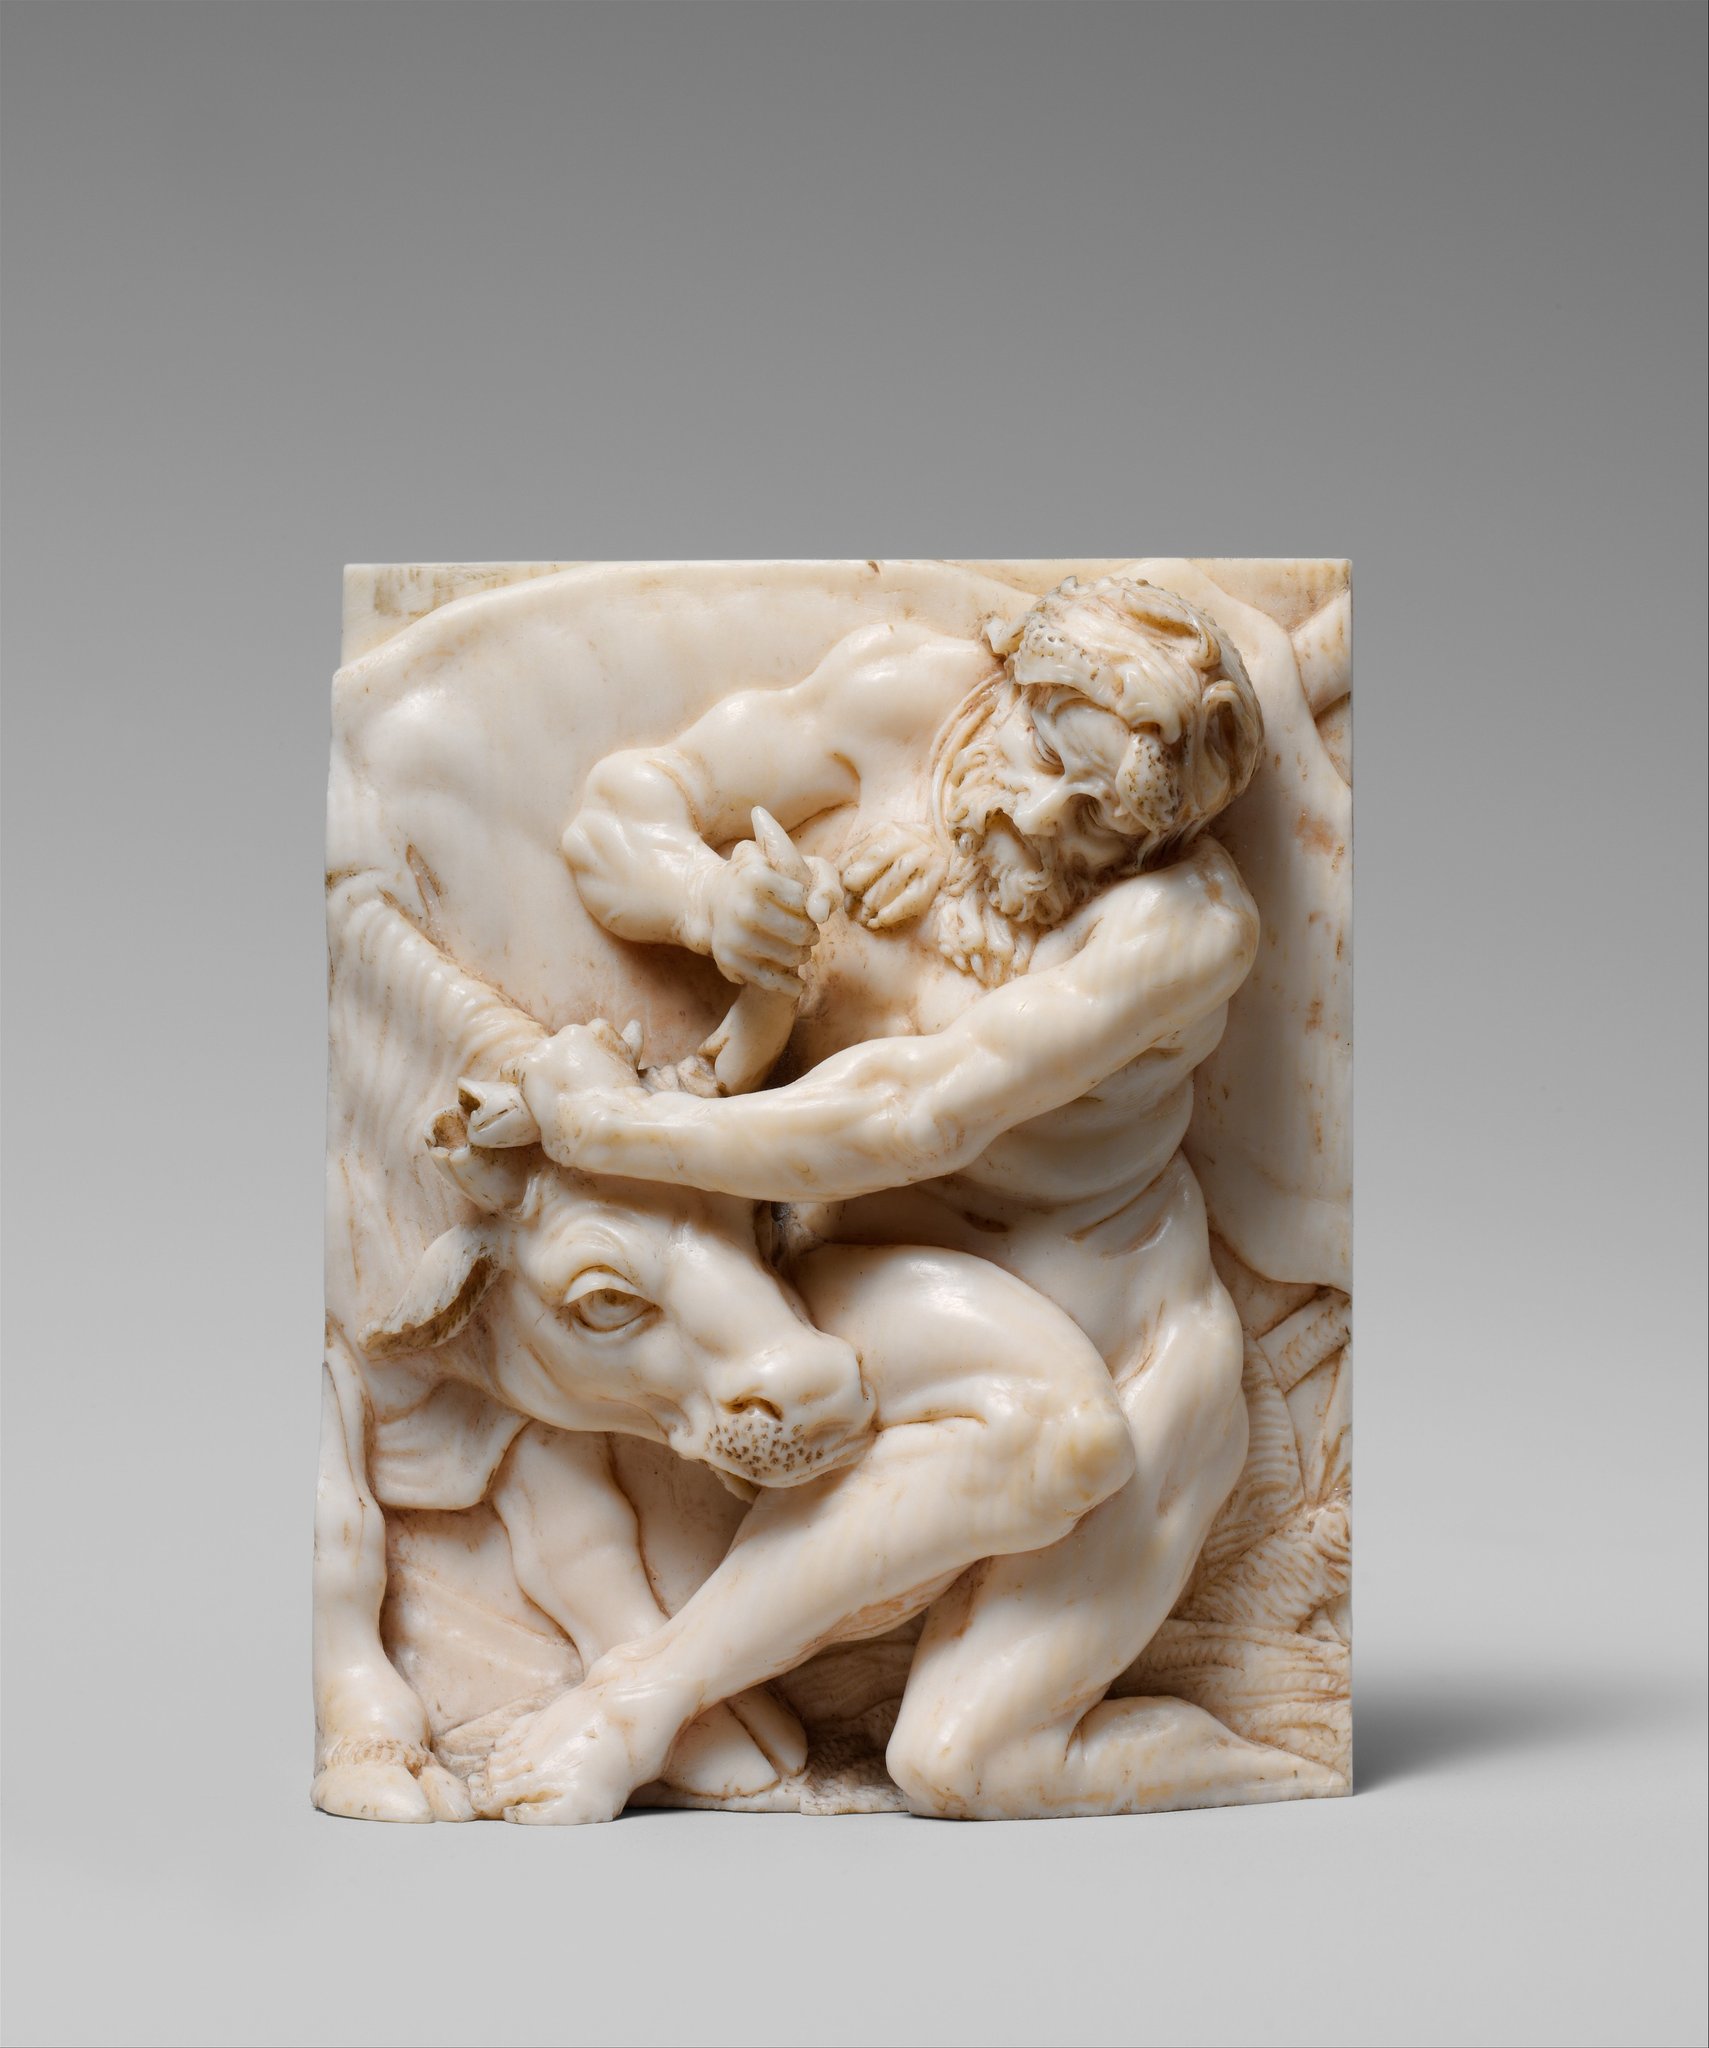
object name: plaque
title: Hercules and Achelous (in the form of a bull)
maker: master of the martyrdom of st. sebastian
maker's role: maker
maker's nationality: austrian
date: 1670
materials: ivory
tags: hercules,bulls